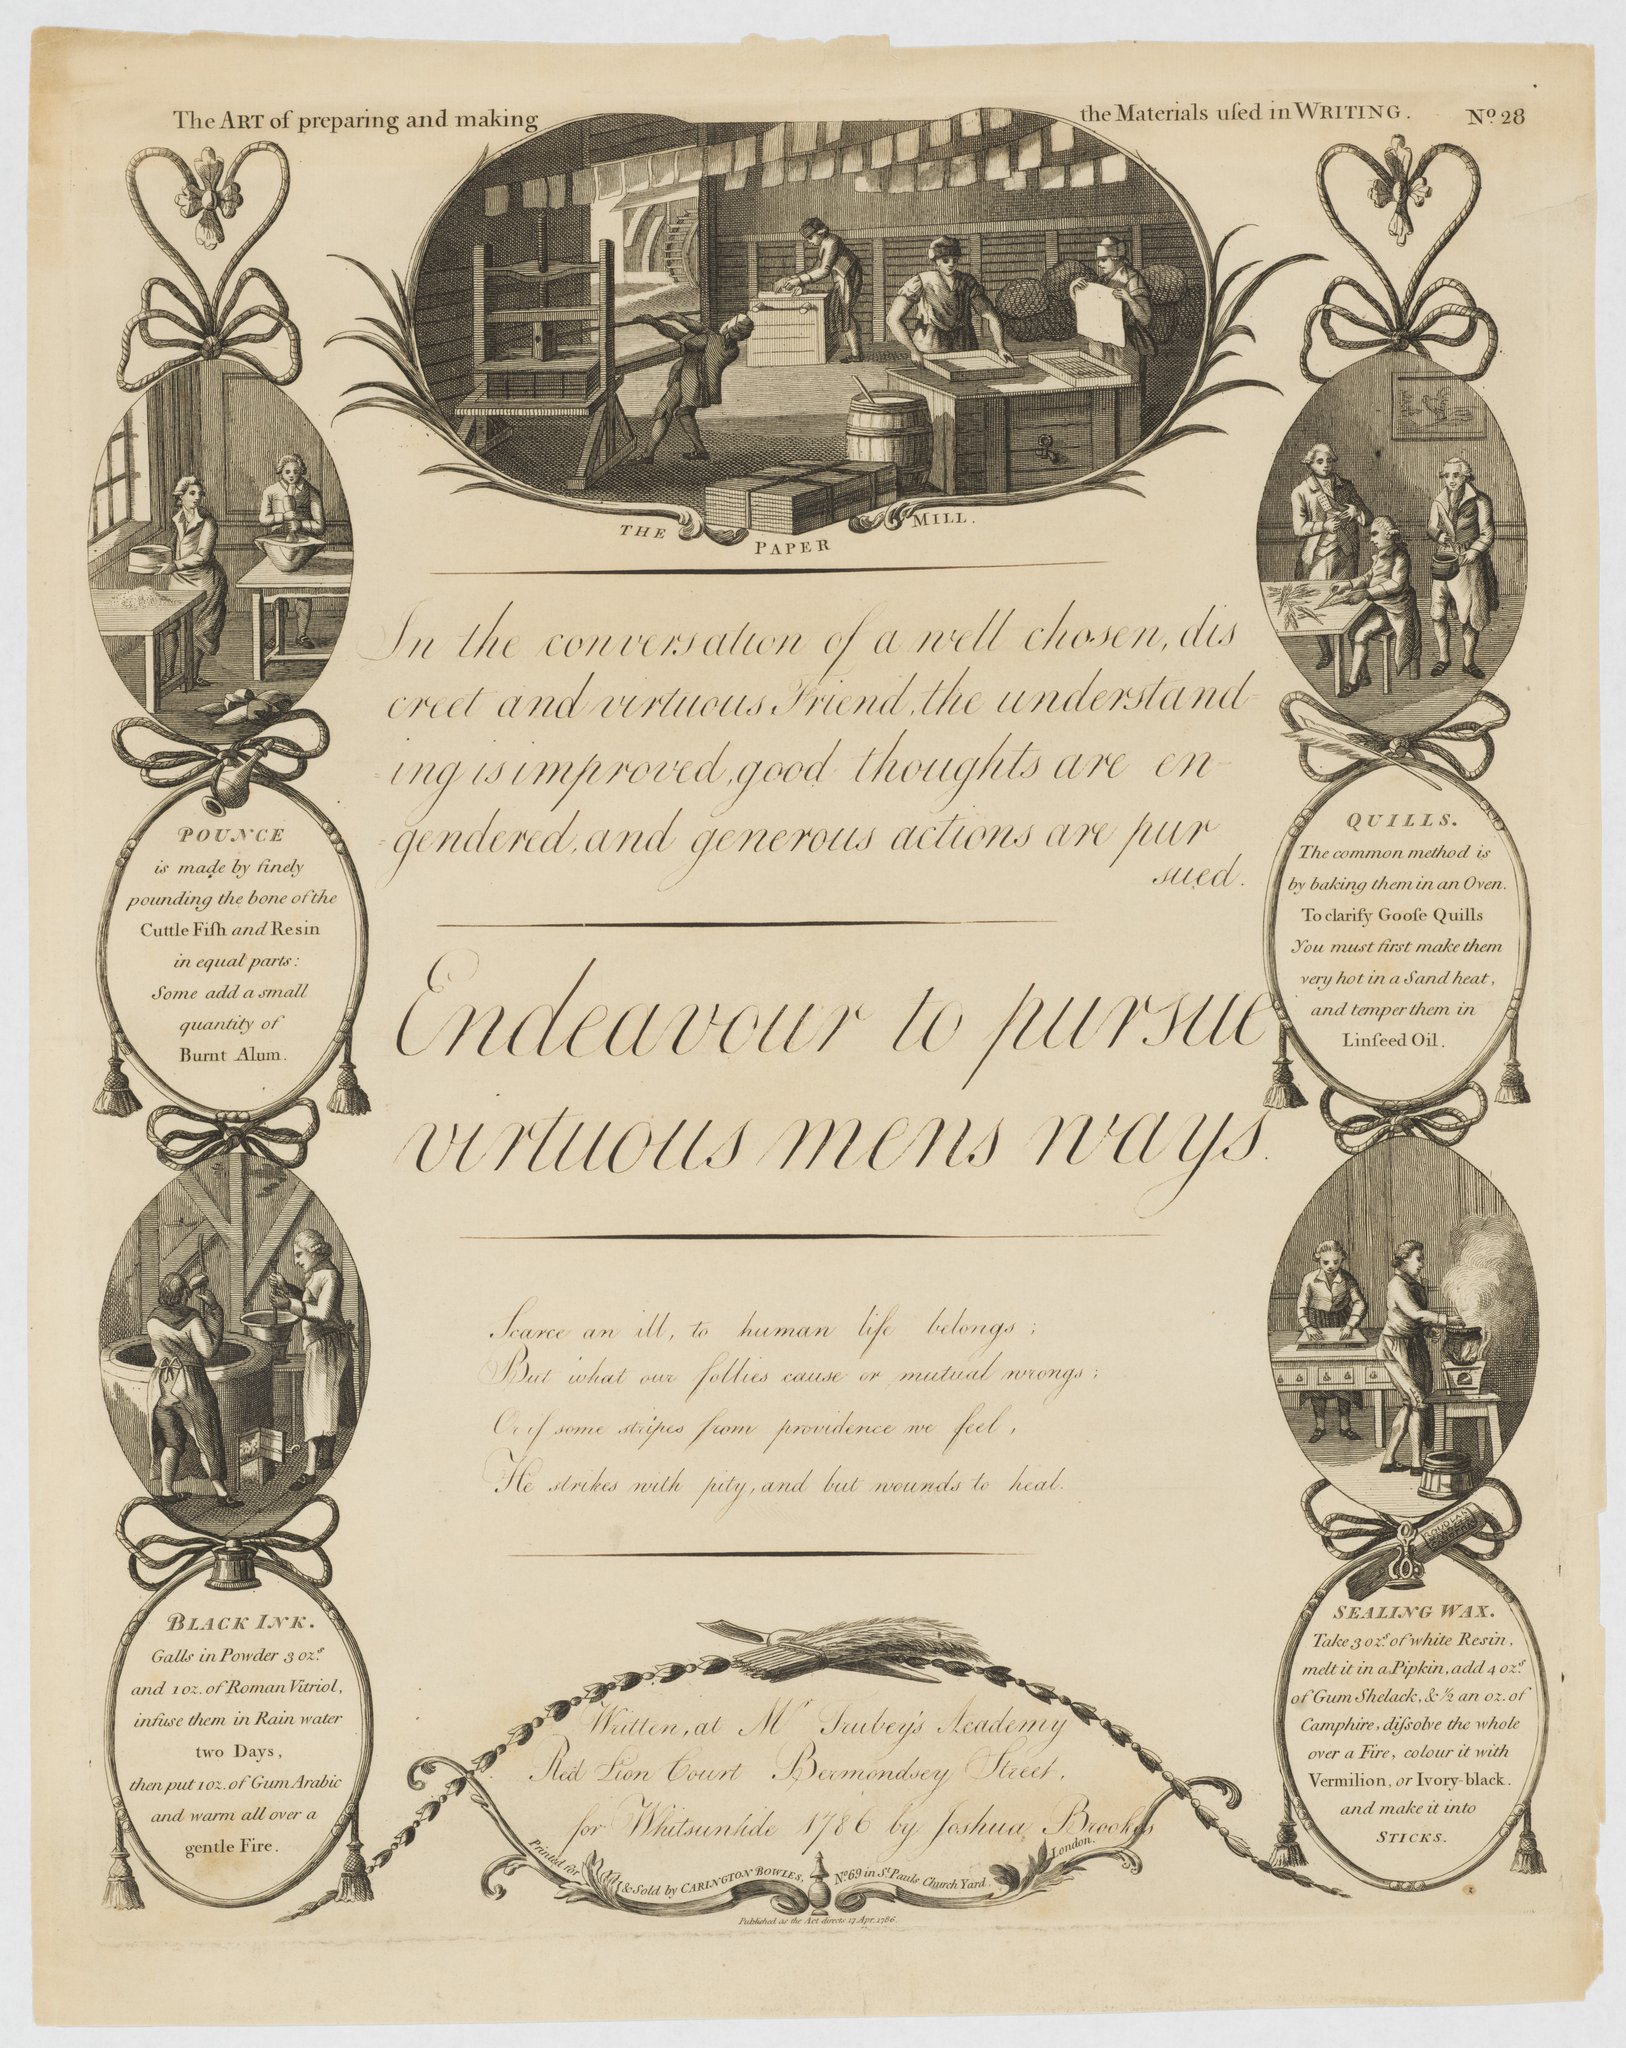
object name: print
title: The Art of Preparing and Making the Materials used in Writing [School piece or Penmanship sheet]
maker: carington bowles i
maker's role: publisher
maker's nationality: british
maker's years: 1724-1793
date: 1786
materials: ink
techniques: engraving, etching, pen